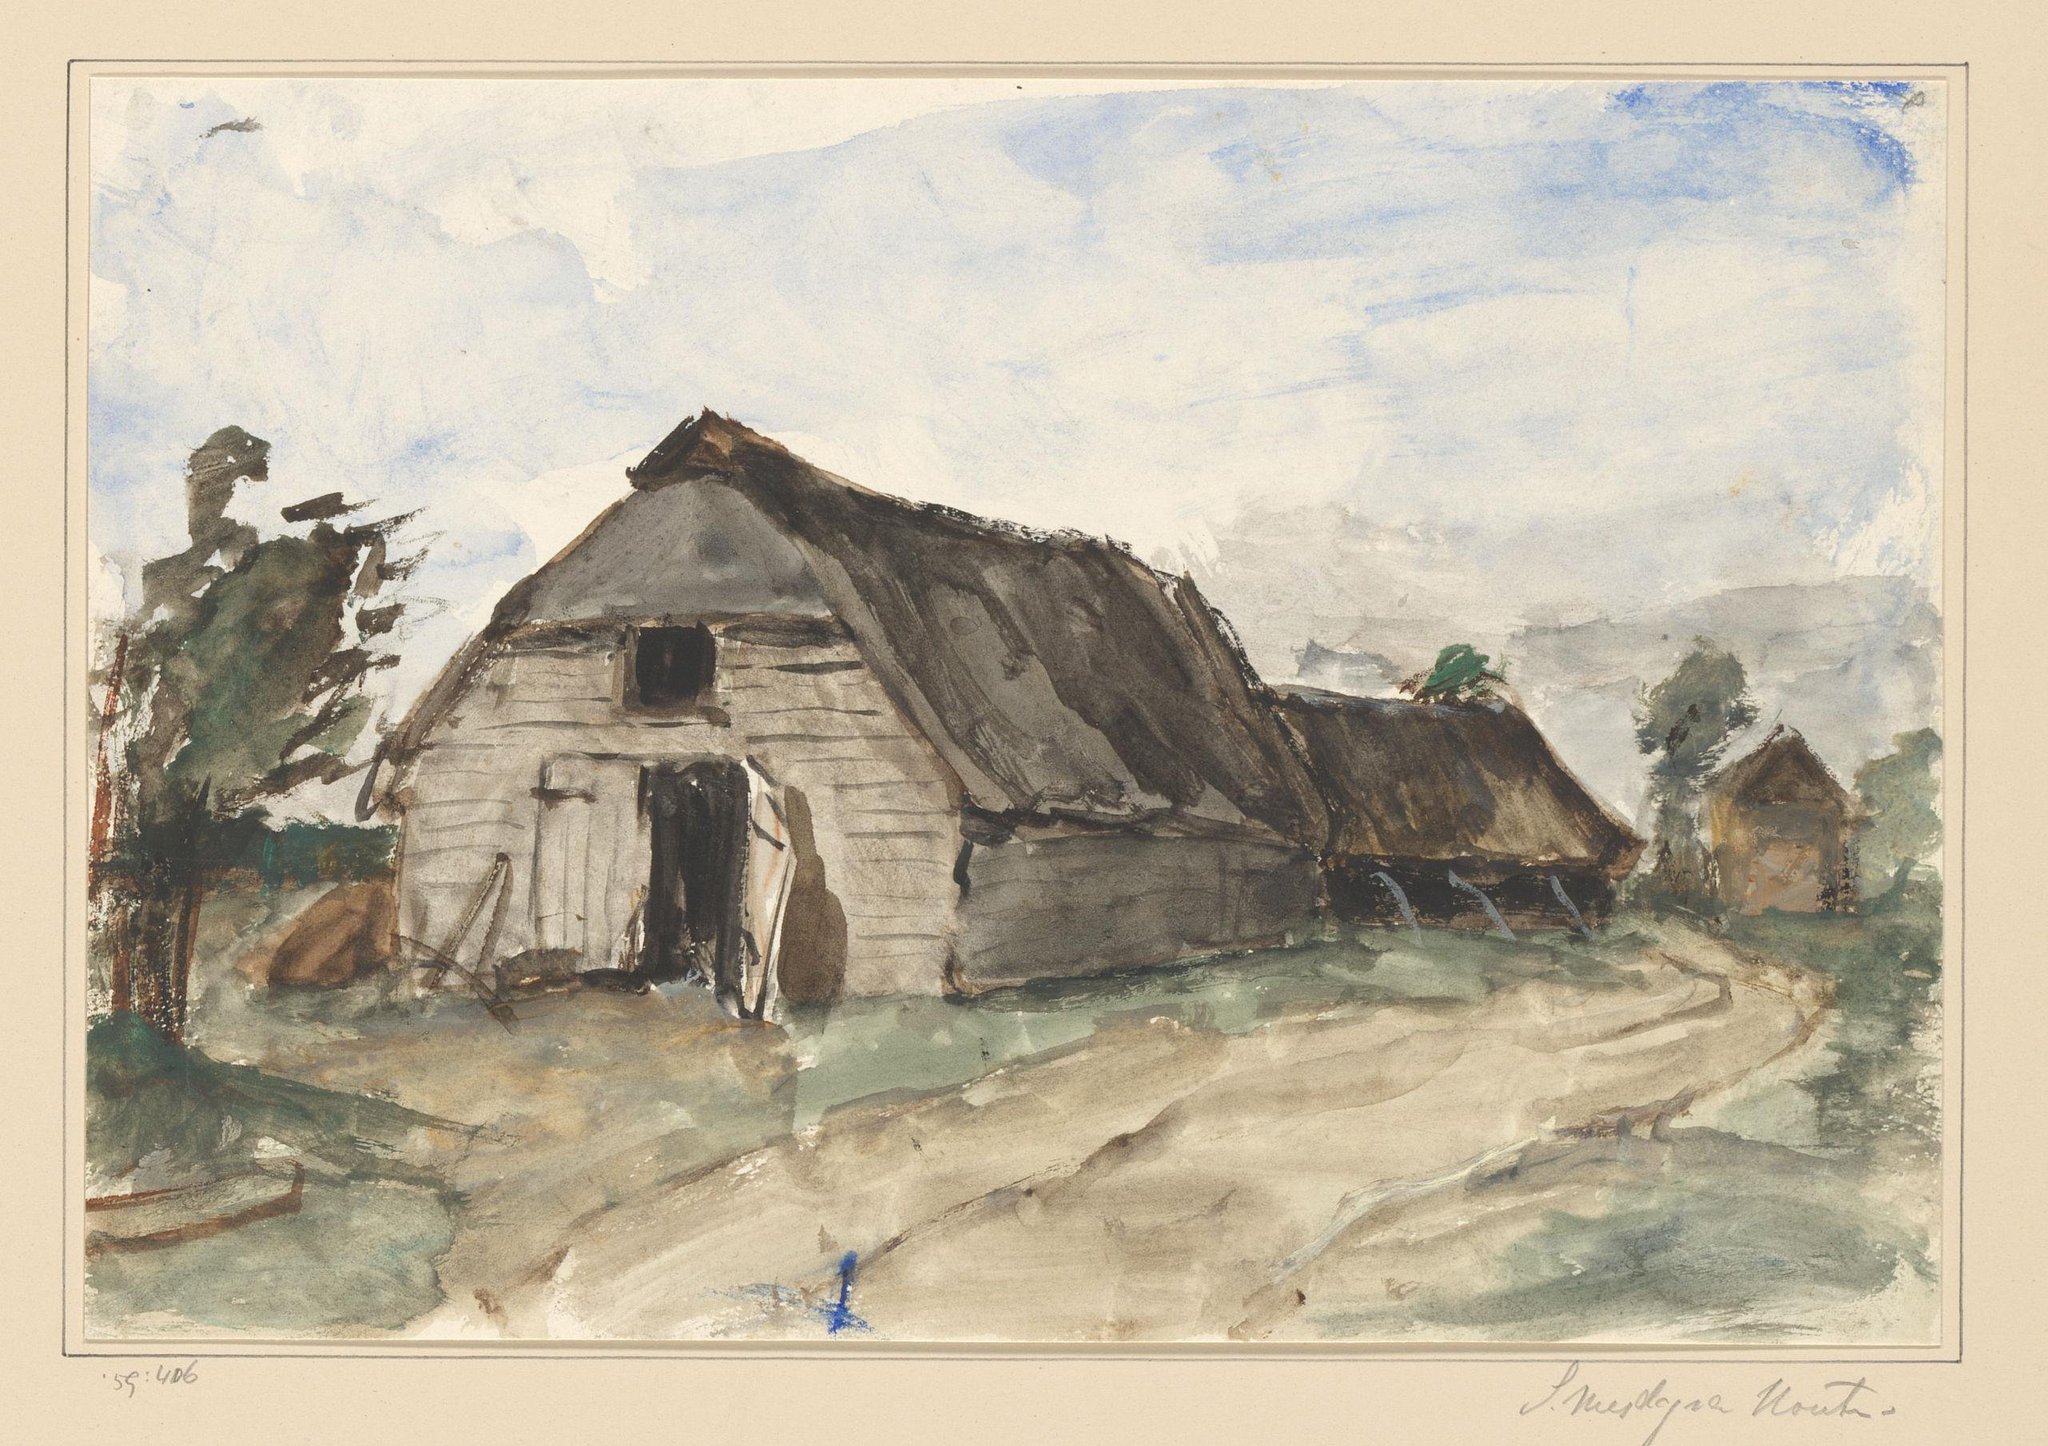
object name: drawing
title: Stal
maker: sientje mesdag-van houten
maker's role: draughtsman, painter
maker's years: 1834-1909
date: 1856-1909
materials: paper, watercolor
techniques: brush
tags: shed